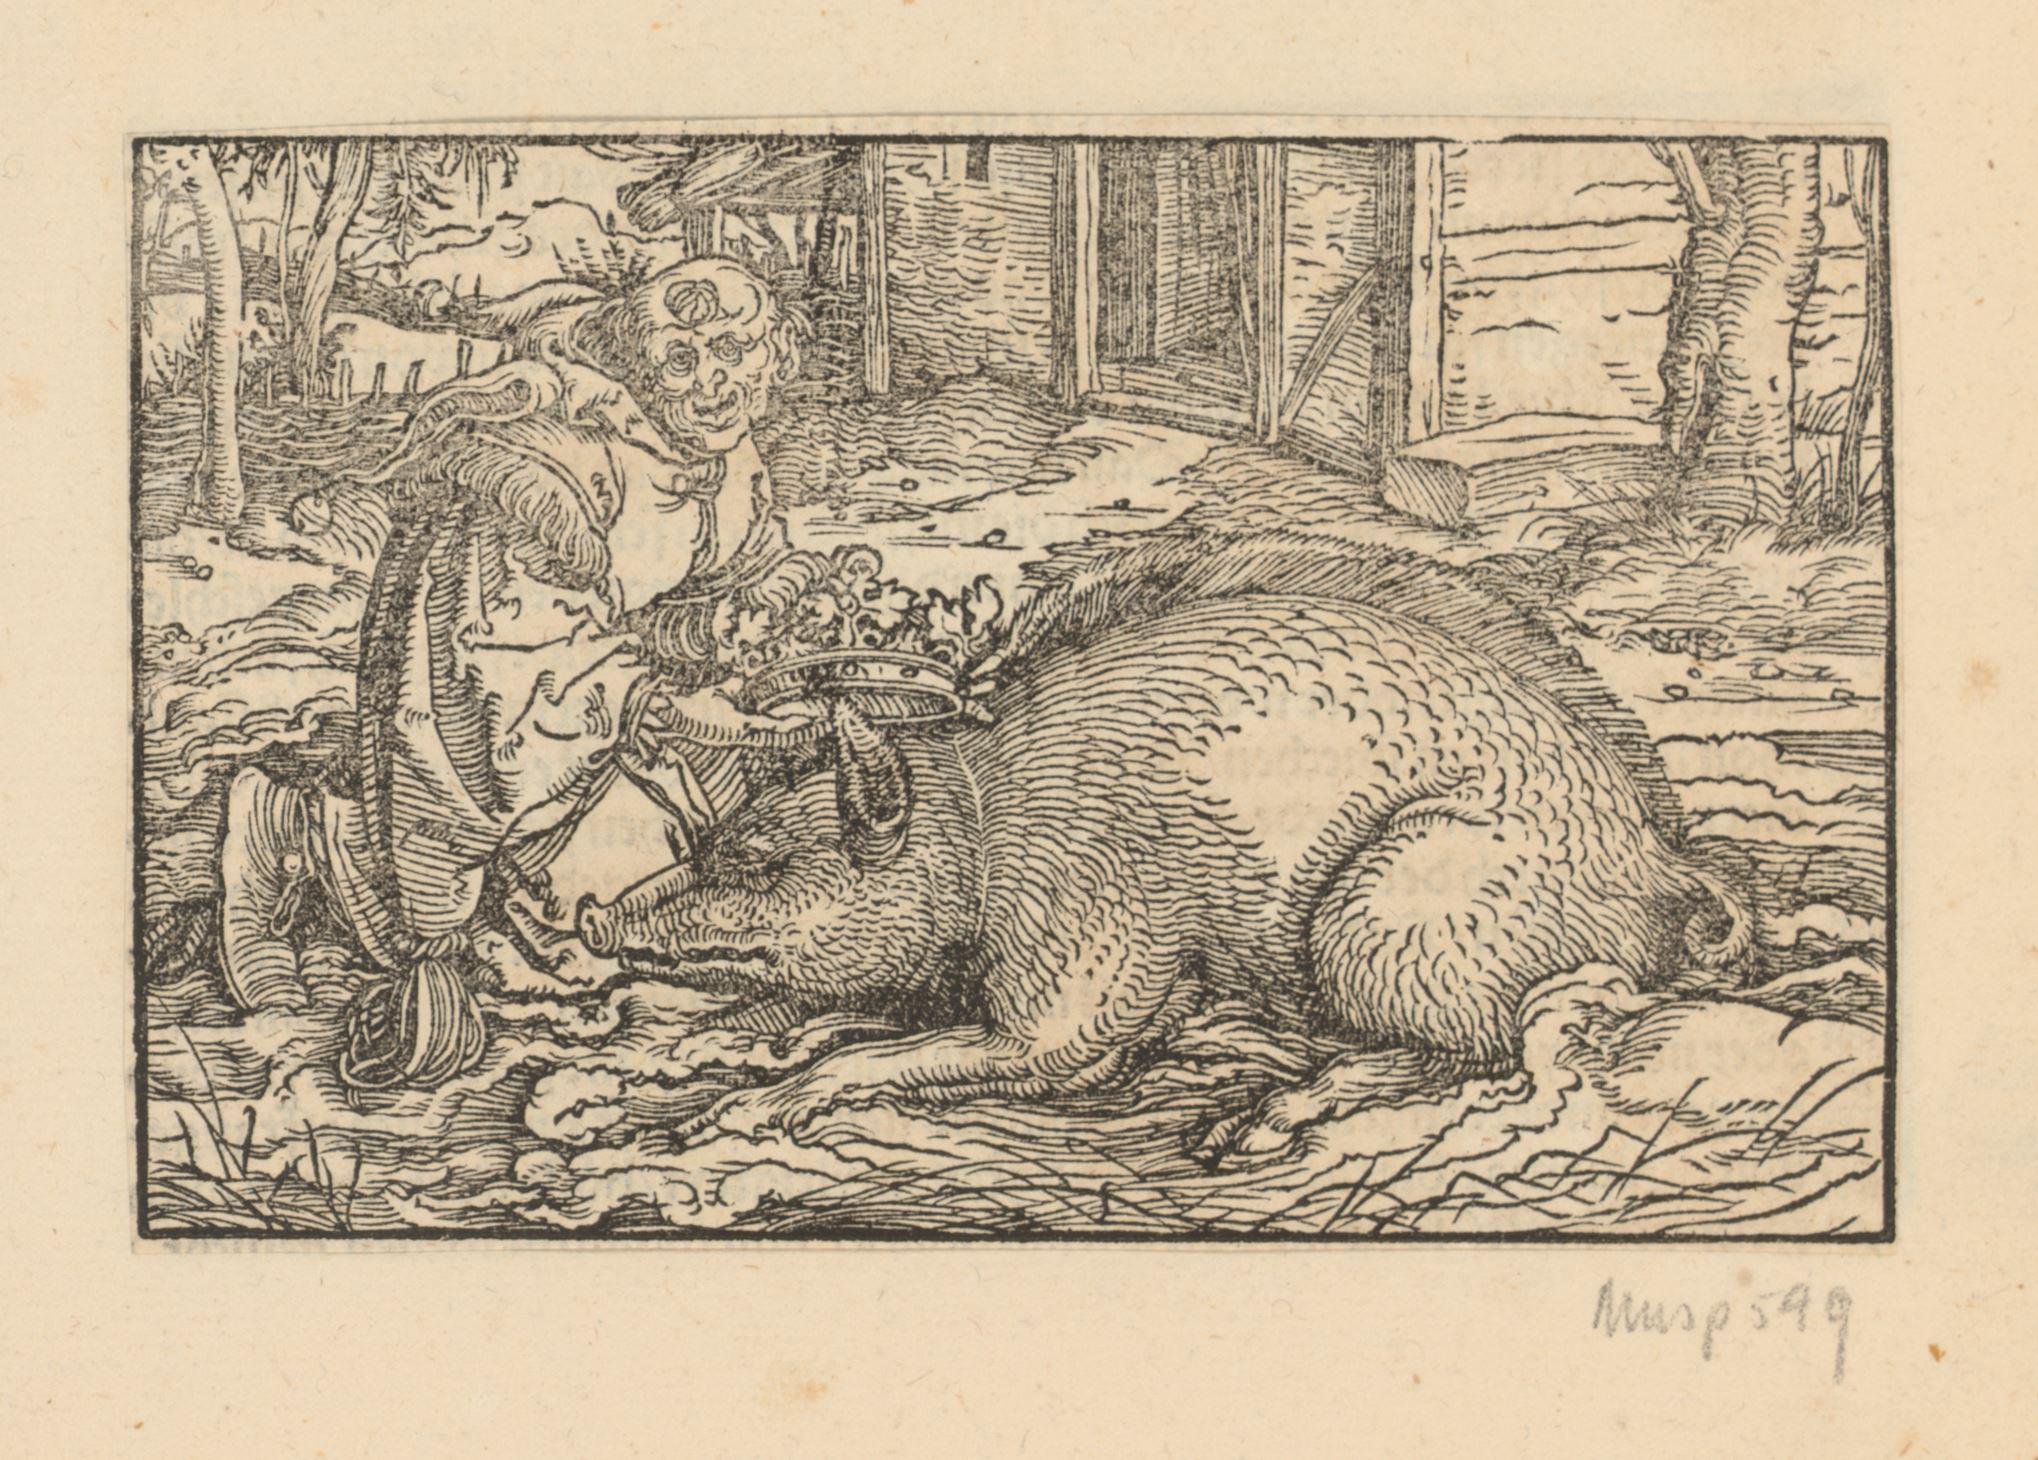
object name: book illustration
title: Man kroont een zwijn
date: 1514-1531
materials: paper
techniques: letterpress printing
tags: crown (symbol of sovereignty), boar (male pig), fool, simpleton, numskull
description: Deze prent is gebruikt in: Cicero, Marcus Tulius. Officia M.T.C. Ein Buch so Marcus Tullius Cicero der Römer zu seynem (...). [Vertaald uit het Latijn door] Johann von Schwarzenberg. Augsburg: Heinrich Steiner, 1531.